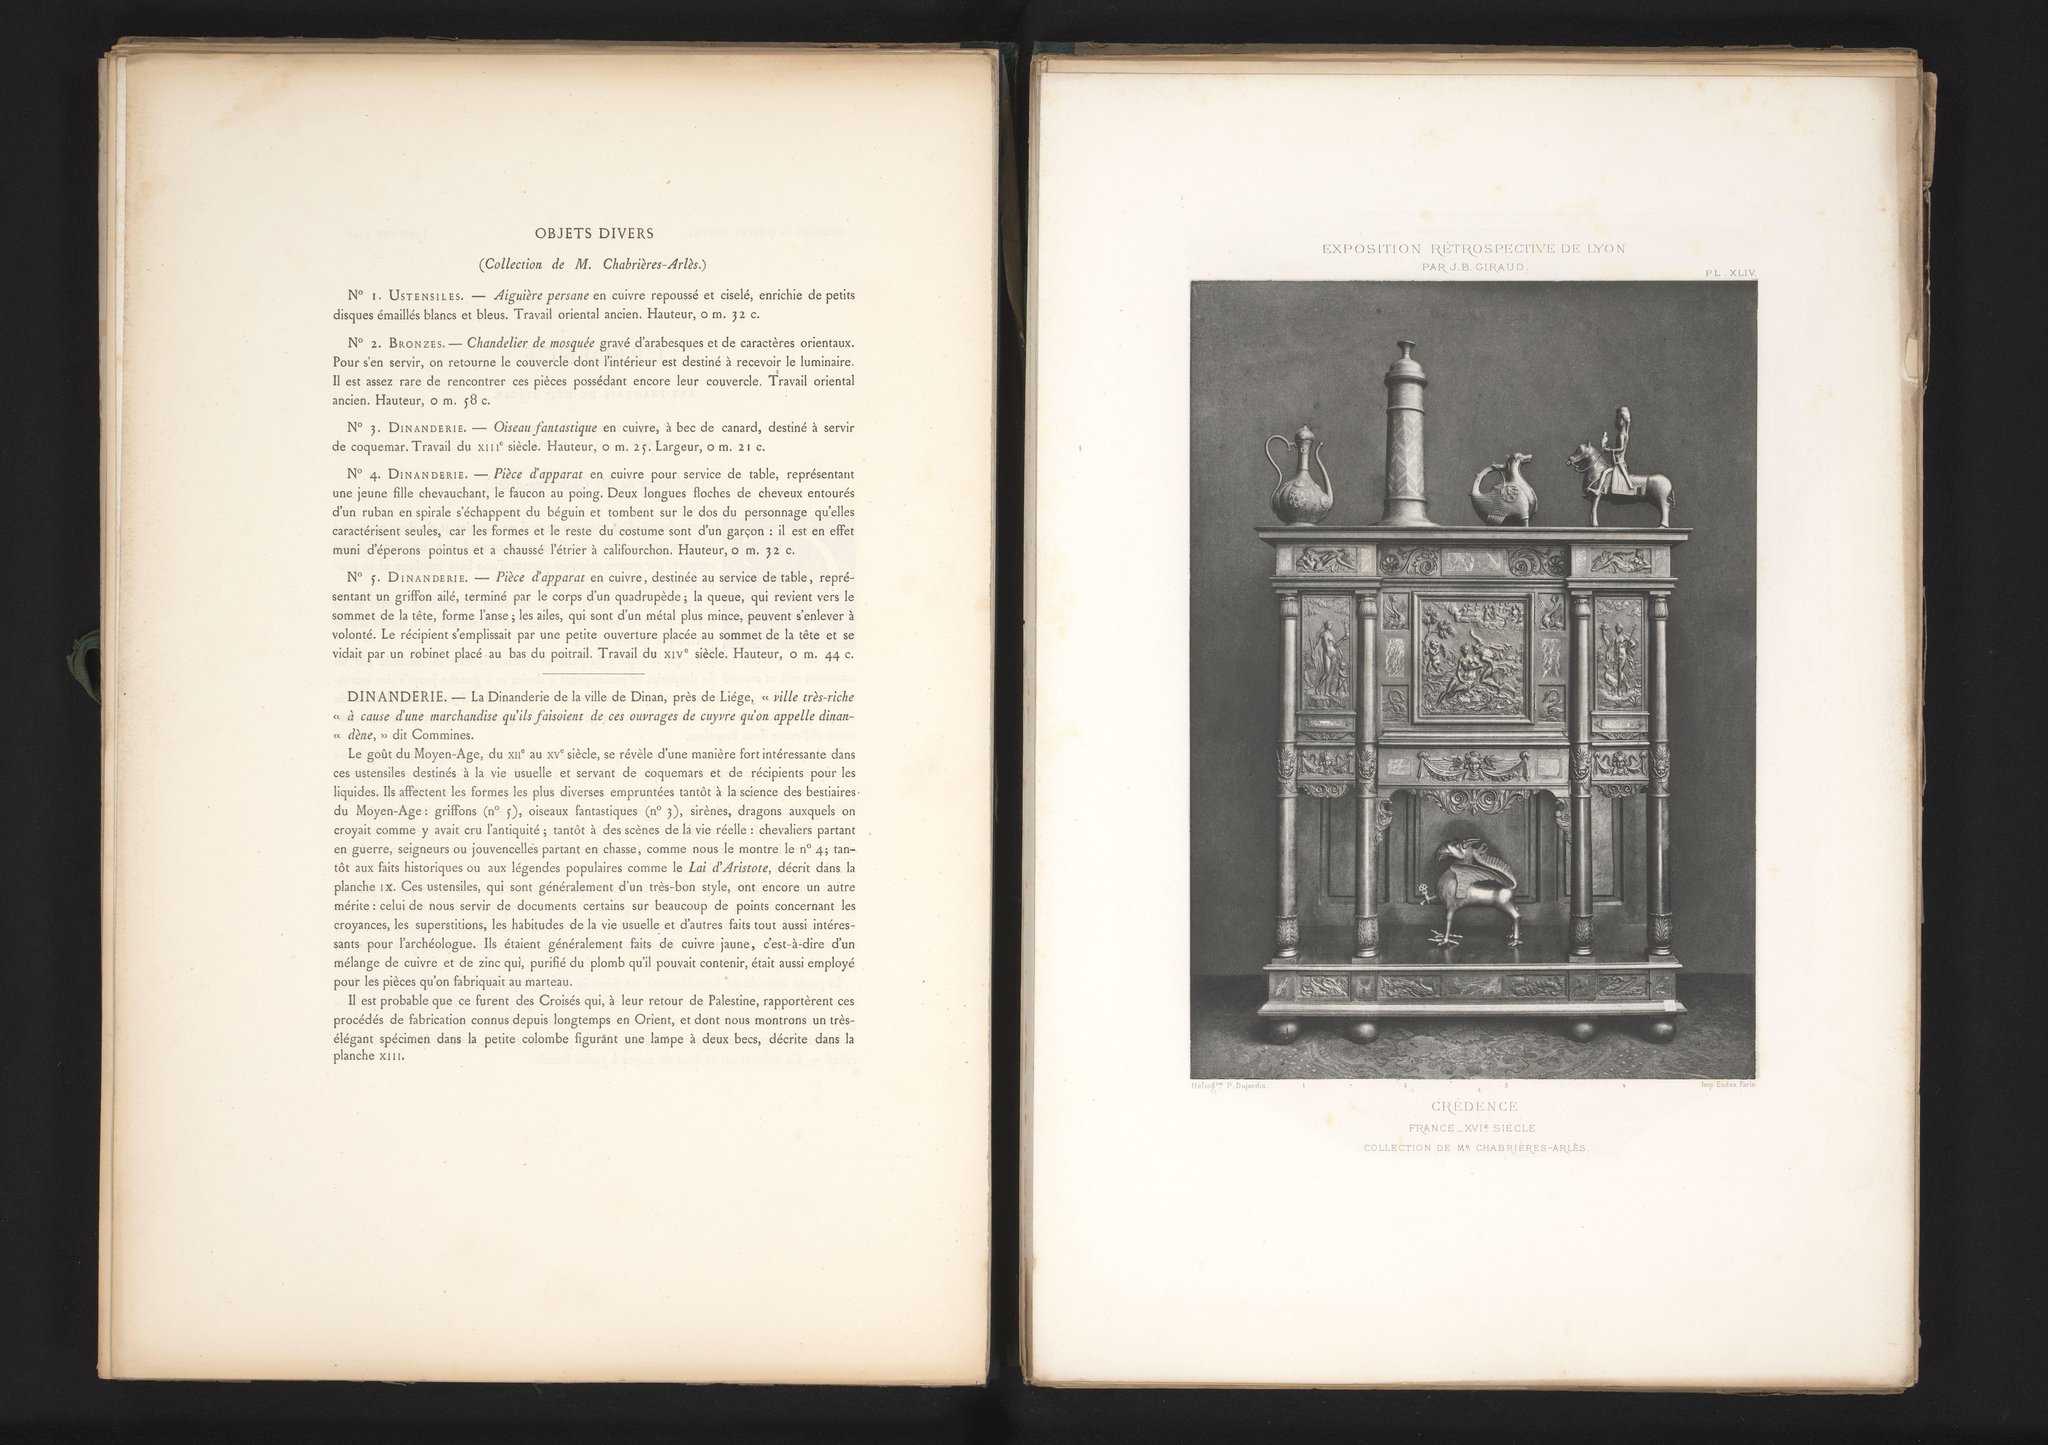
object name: photomechanical print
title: 16de-eeuws Frans dressoir van hout, op de Exposition Rétrospective van 1877 in Lyon, Frankrijk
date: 1877-1878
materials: paper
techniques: photoaquatint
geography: lyon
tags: ornamental cupboard (+ wood and other phytogenic material), lyon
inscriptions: inscription: ‘CRÉDENCE/ FRANCE_XVIe SIÈCLE/ COLLECTION DE Mr CHABRIÈRES-ARLÈS.’, inscription: ‘EXPOSITION RÉTROSPECTIVE DE LYON/ PAR J. B. GIRAUD.’, number: ‘PL. XLIV.’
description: Deze prent maakt deel uit van een omslag met 79 prenten op 54 bladen en 65 tekstbladen.